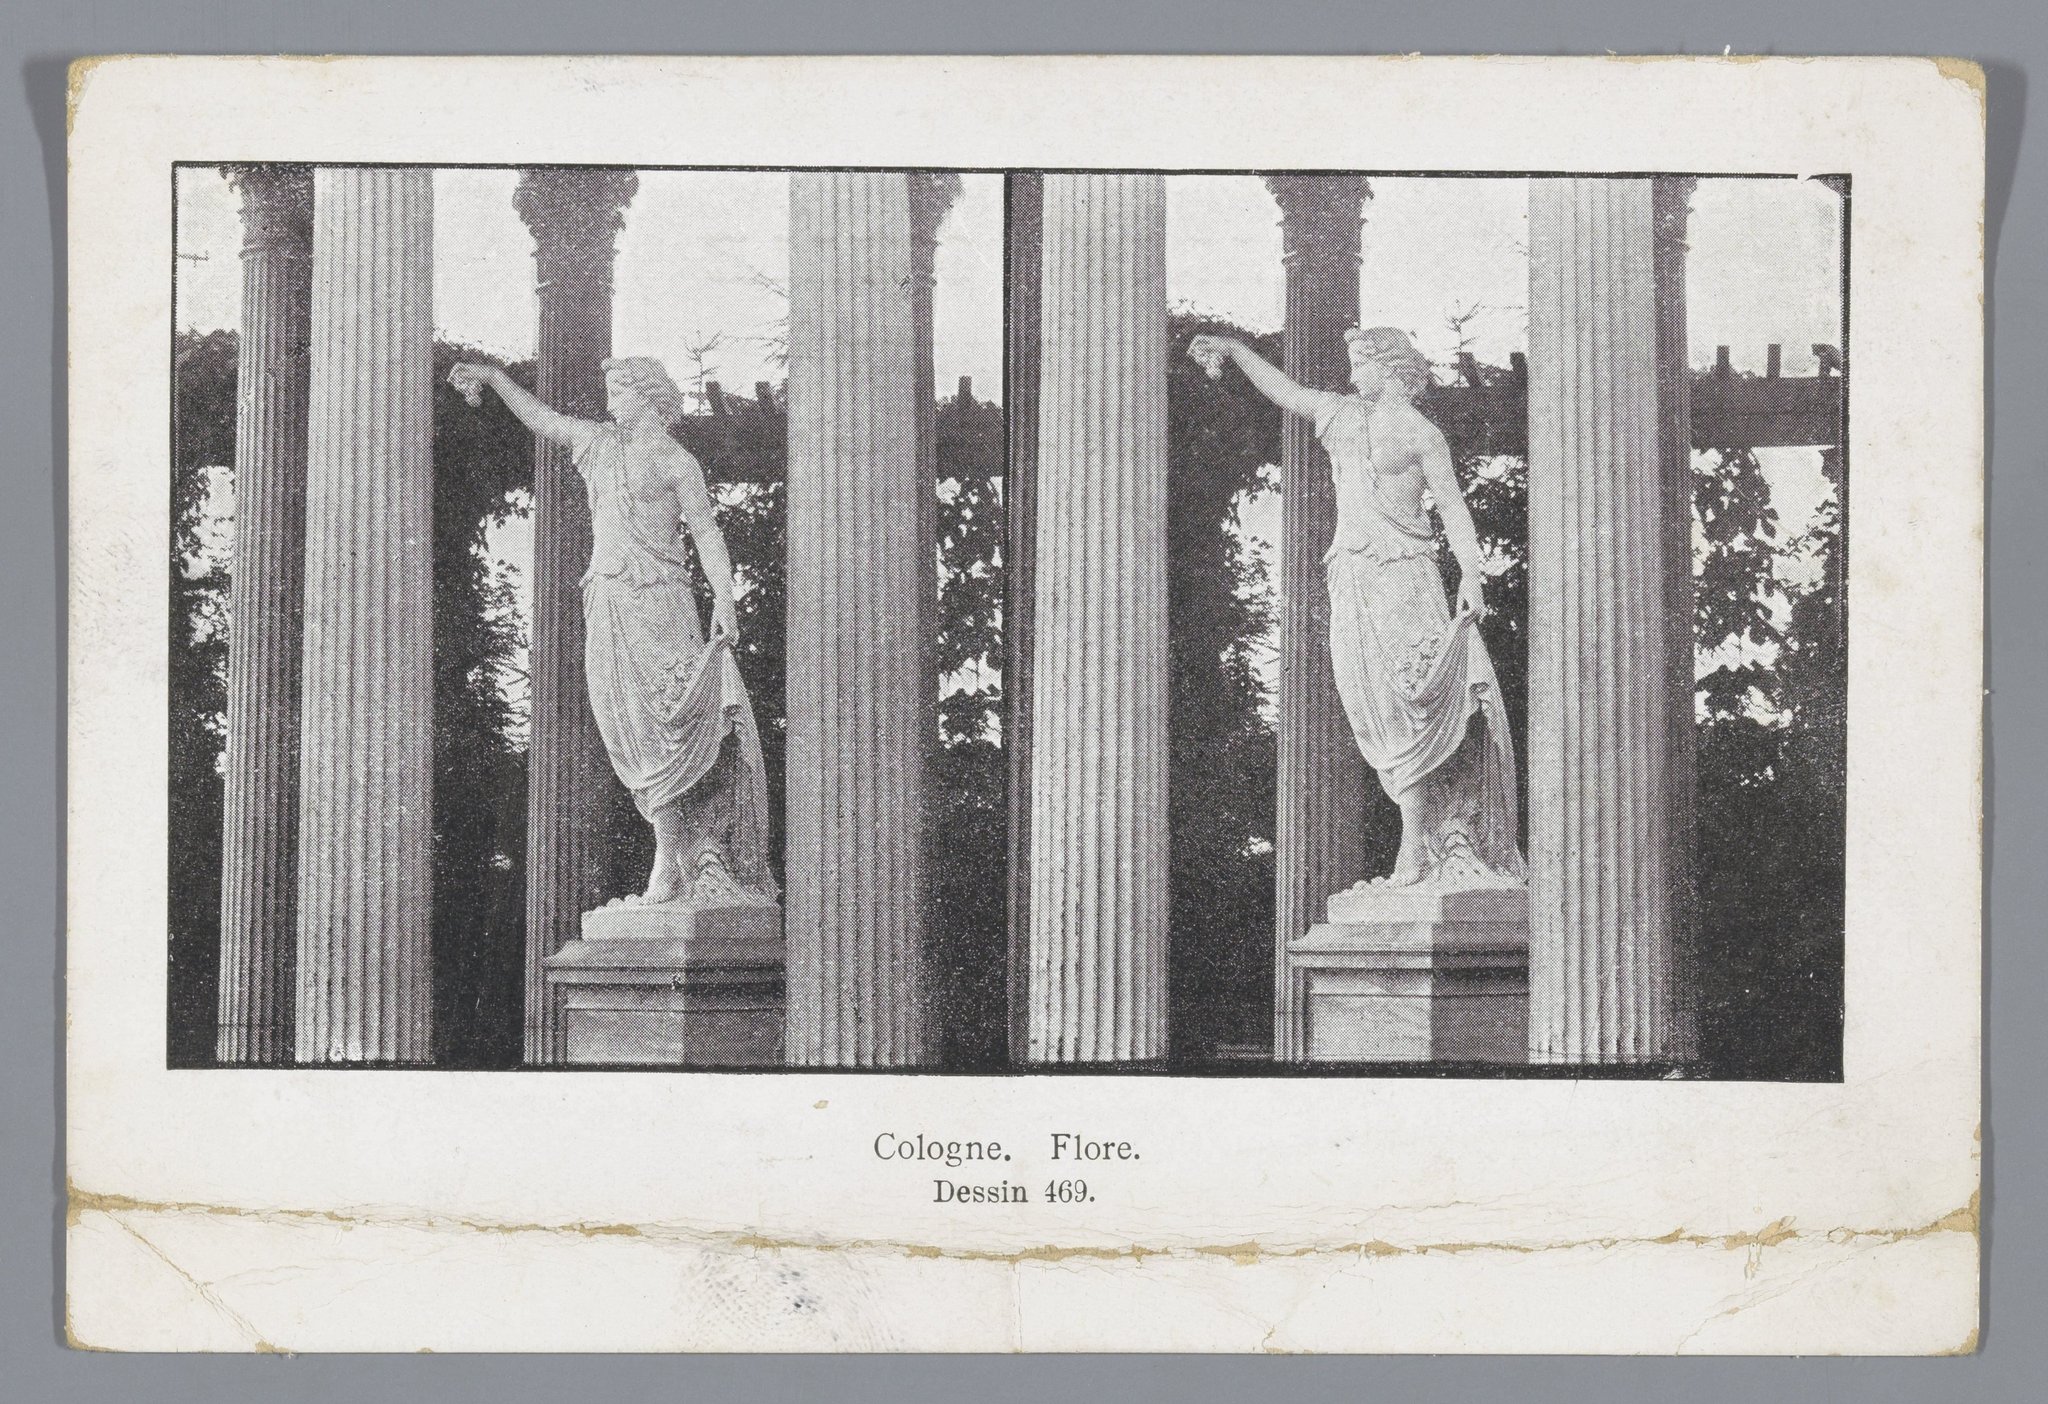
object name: stereograph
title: Cologne. Flore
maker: Anonymous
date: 1890-1905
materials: cardboard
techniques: autotype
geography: cologne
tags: sculpture, (story of) flora, cologne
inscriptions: inscription: ‘Dessin 469.’, inscription: ‘Carte Postale’